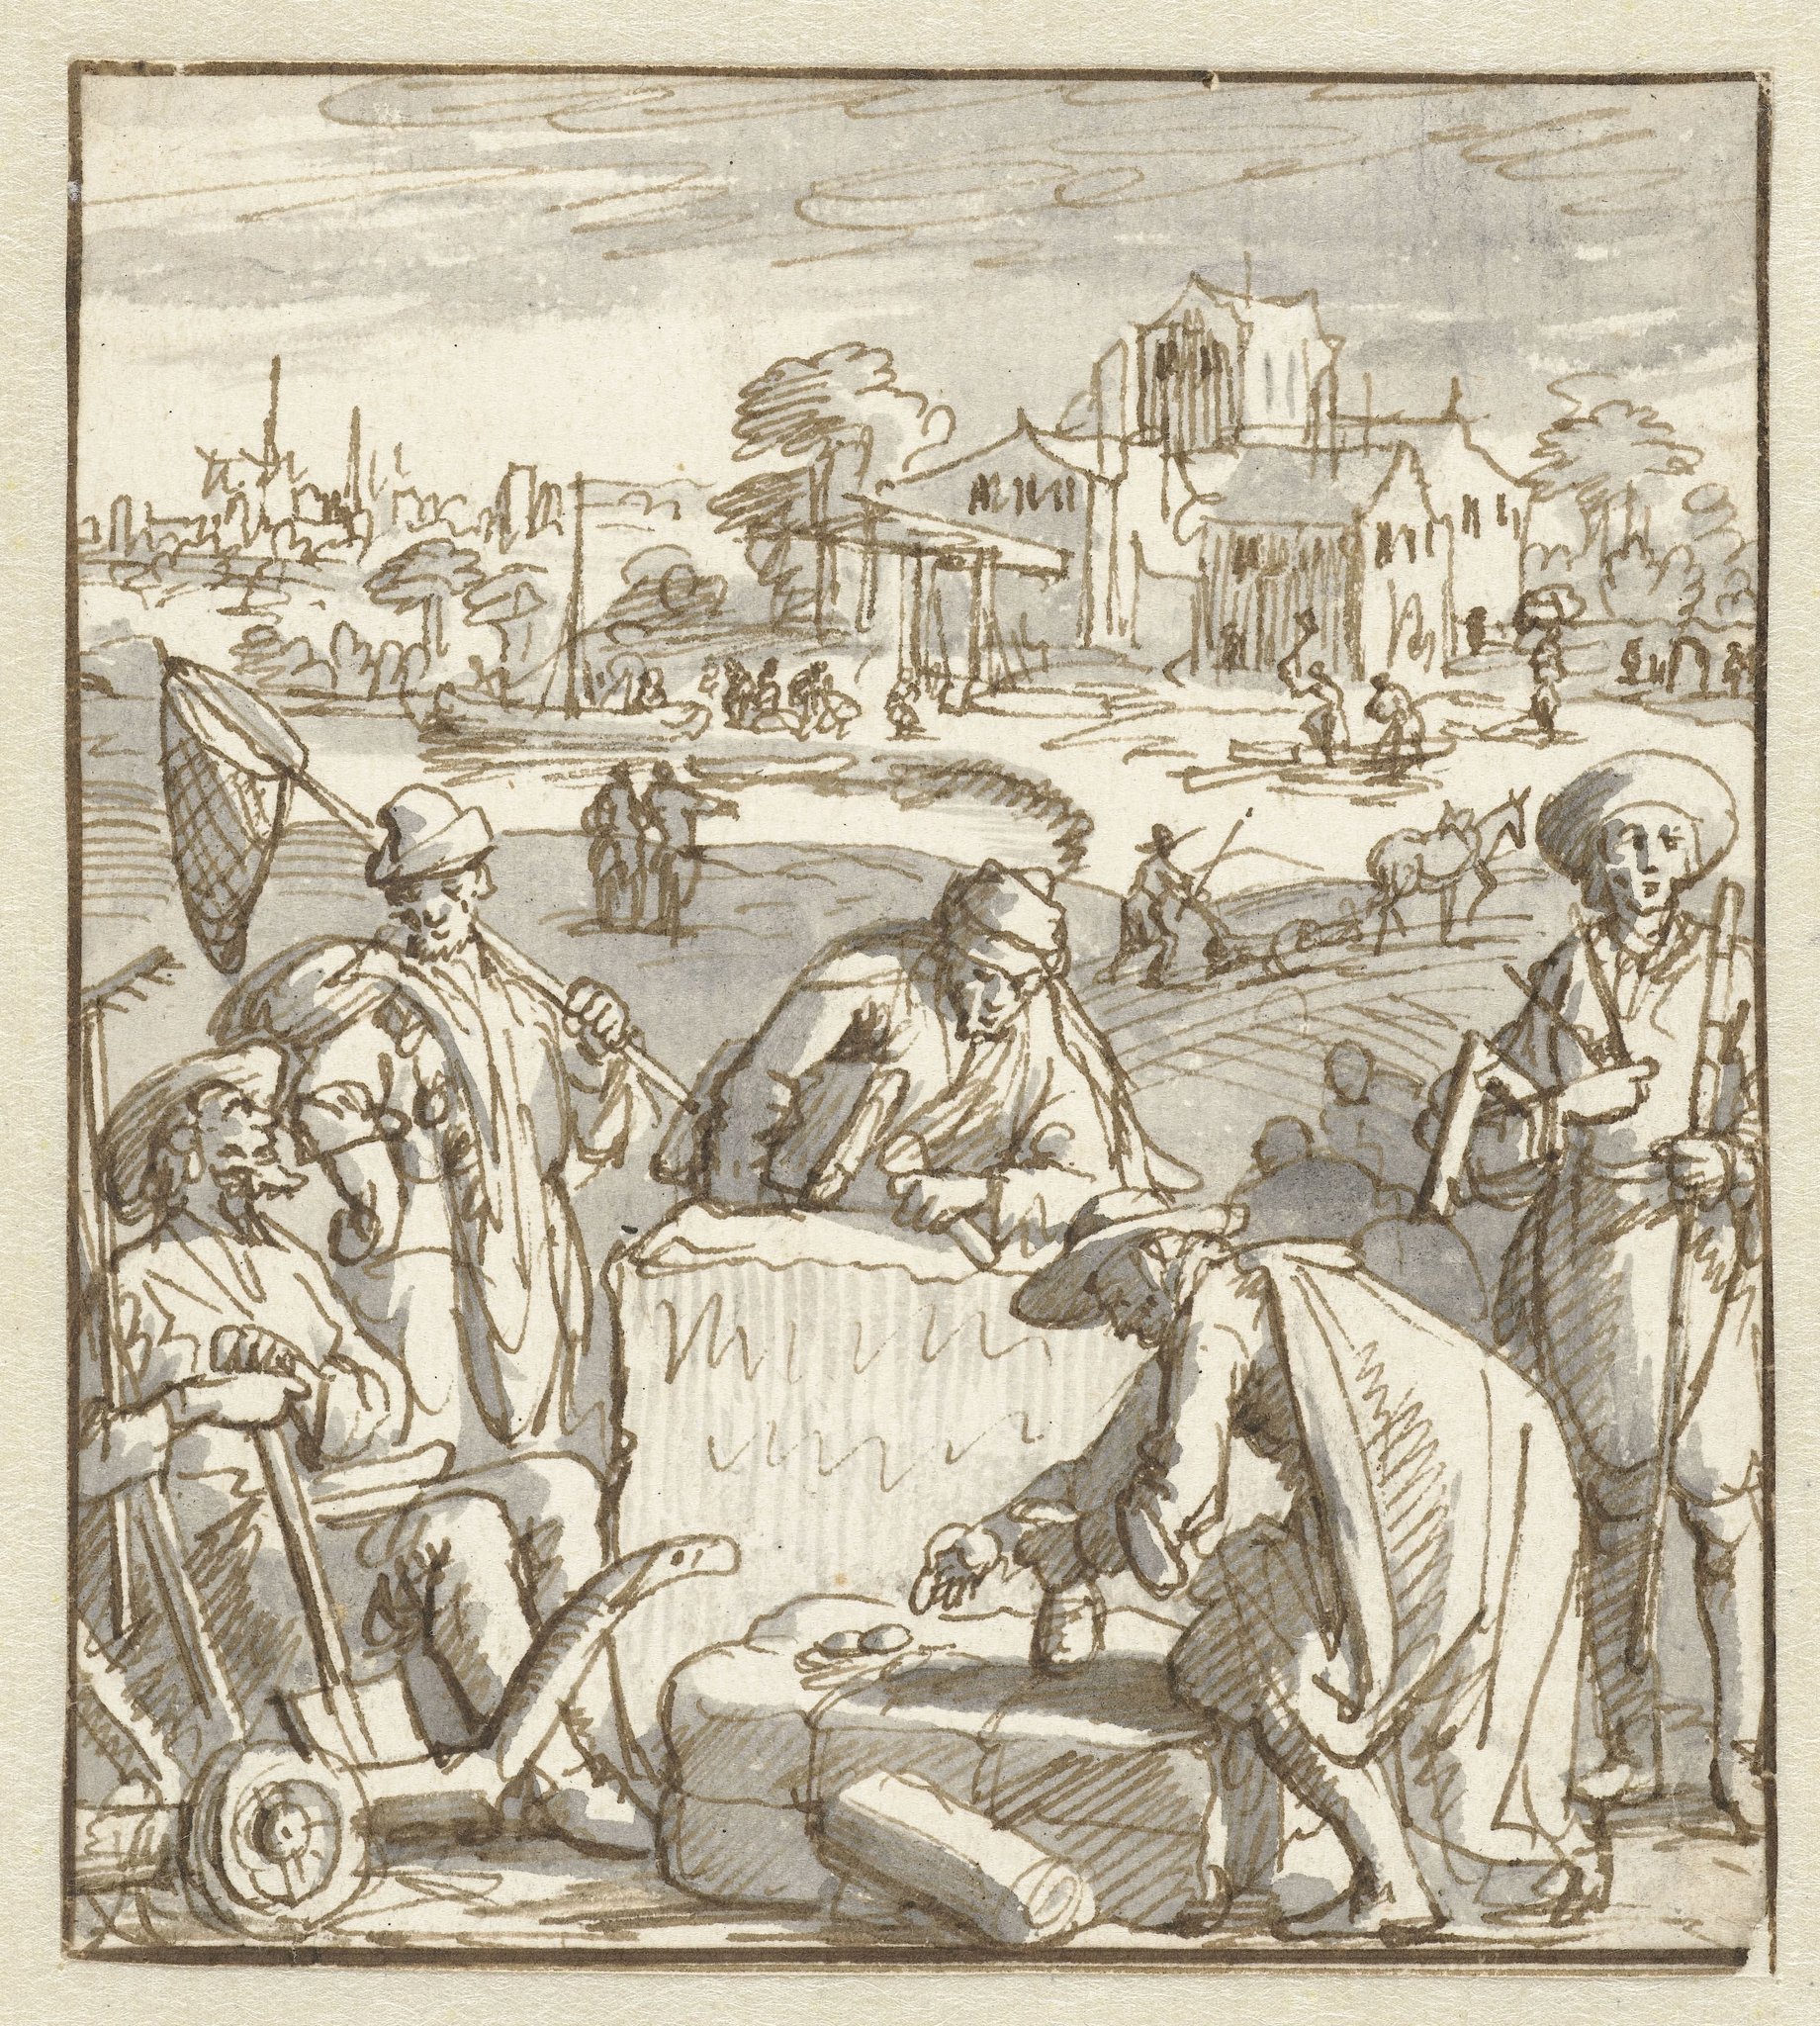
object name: design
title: Ontwerp voor titelprent voor Fondament-steen des Huis, der broeder-lyke Liefde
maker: jan luyken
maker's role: draughtsman, print maker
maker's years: 1649-1712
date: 1684-1686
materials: ink, paper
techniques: brush, pen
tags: commercial fishery, carpenter, scholar, philosopher, farmers, merchant, salesman